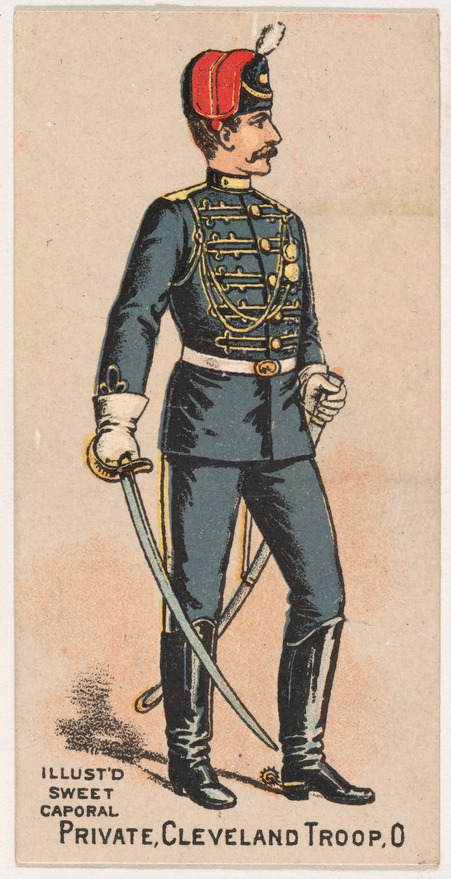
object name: print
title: Private, Cleveland Troop, Ohio, from the Military Series (N224) issued by Kinney Tobacco Company to promote Sweet Caporal Cigarettes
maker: kinney brothers tobacco company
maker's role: publisher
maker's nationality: american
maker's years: 1869-2011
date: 1888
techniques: color lithograph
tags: soldiers,men,profiles